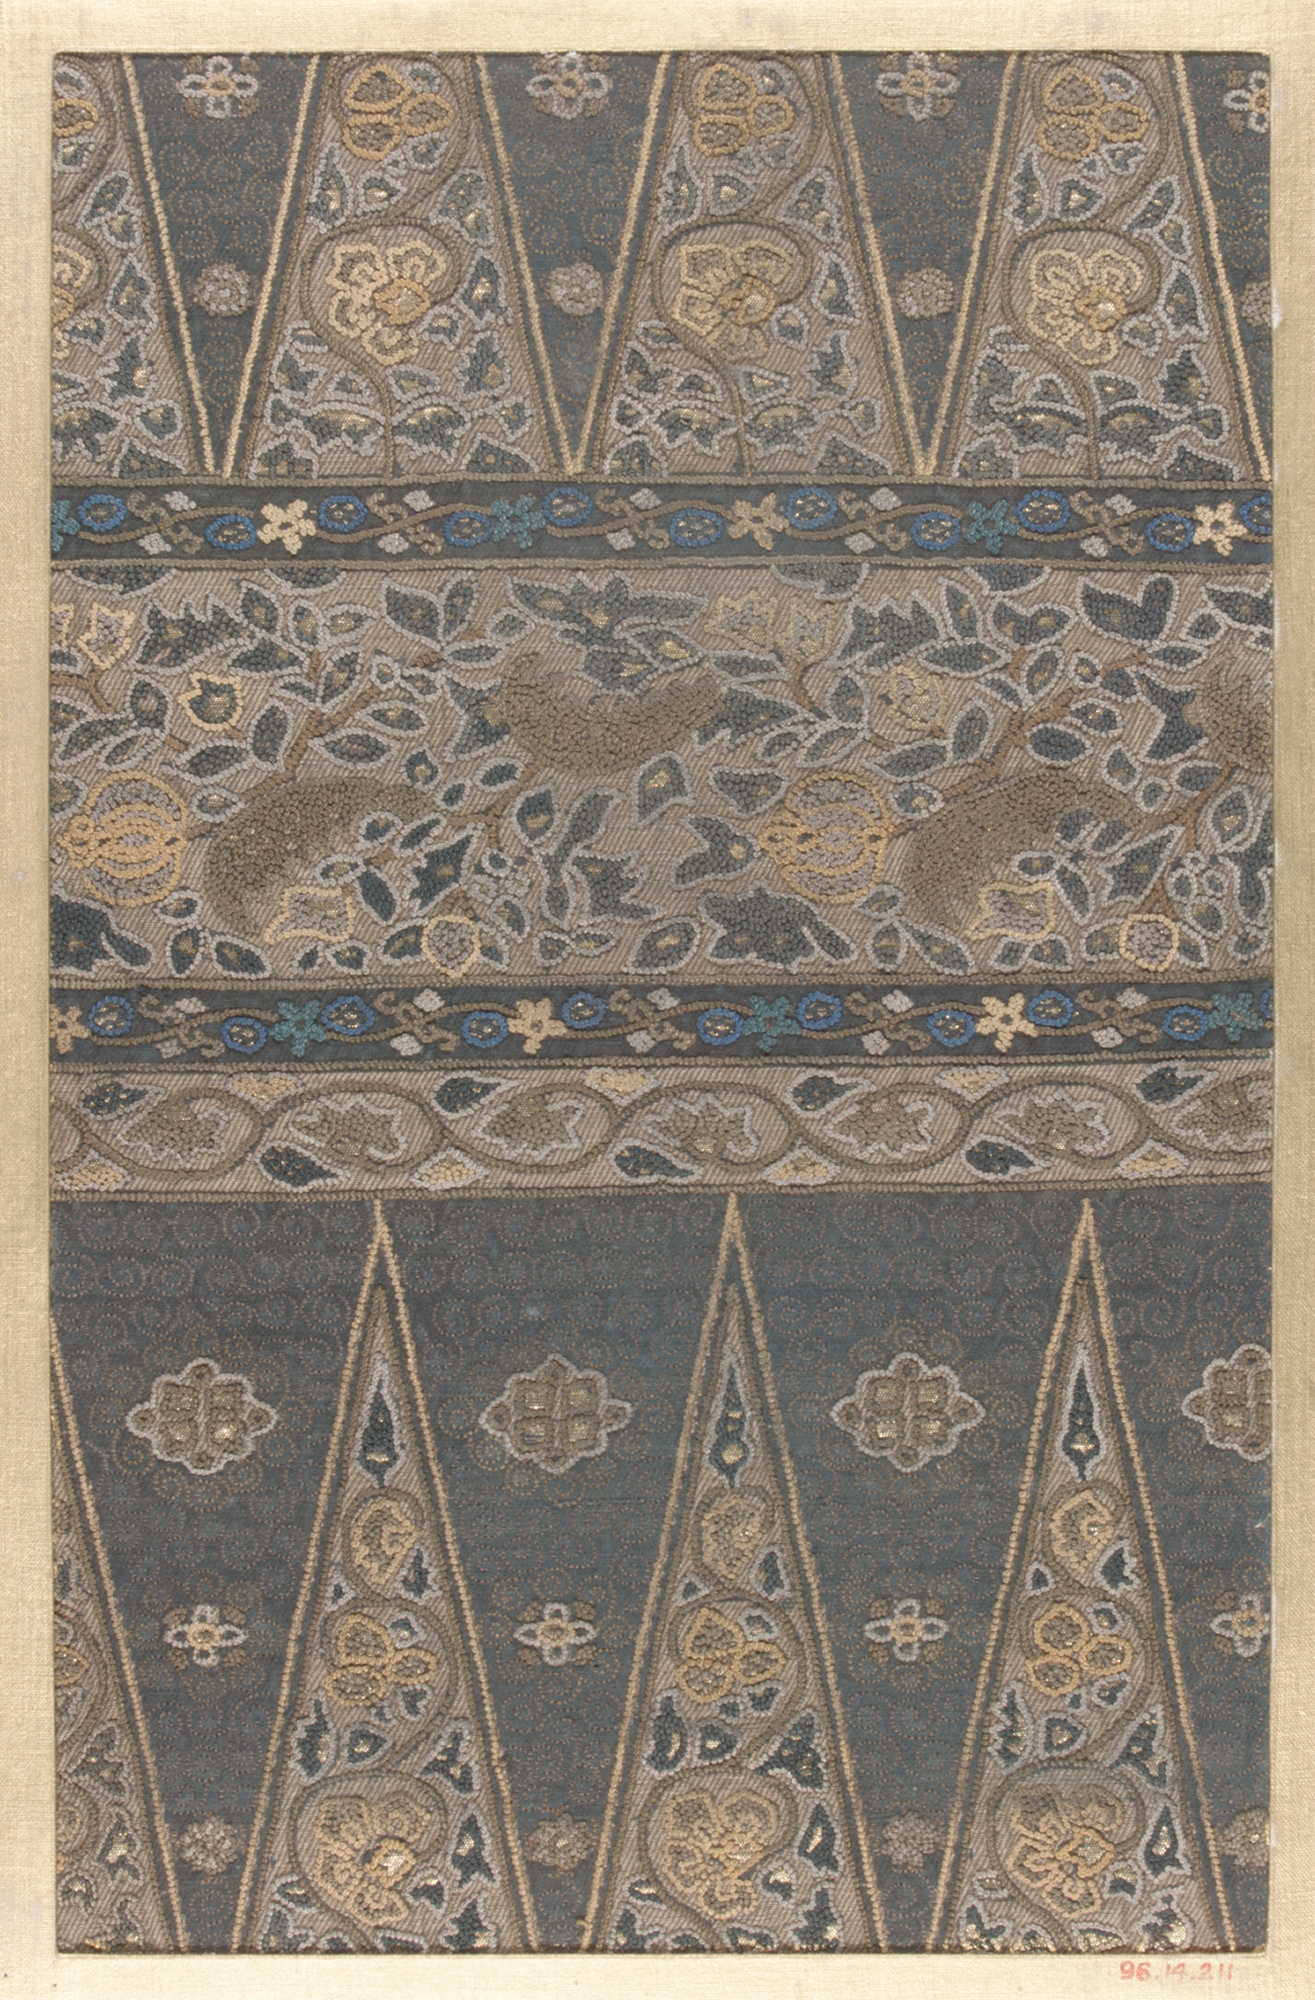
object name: piece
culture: japanese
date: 1701-1900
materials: silk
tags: leaves